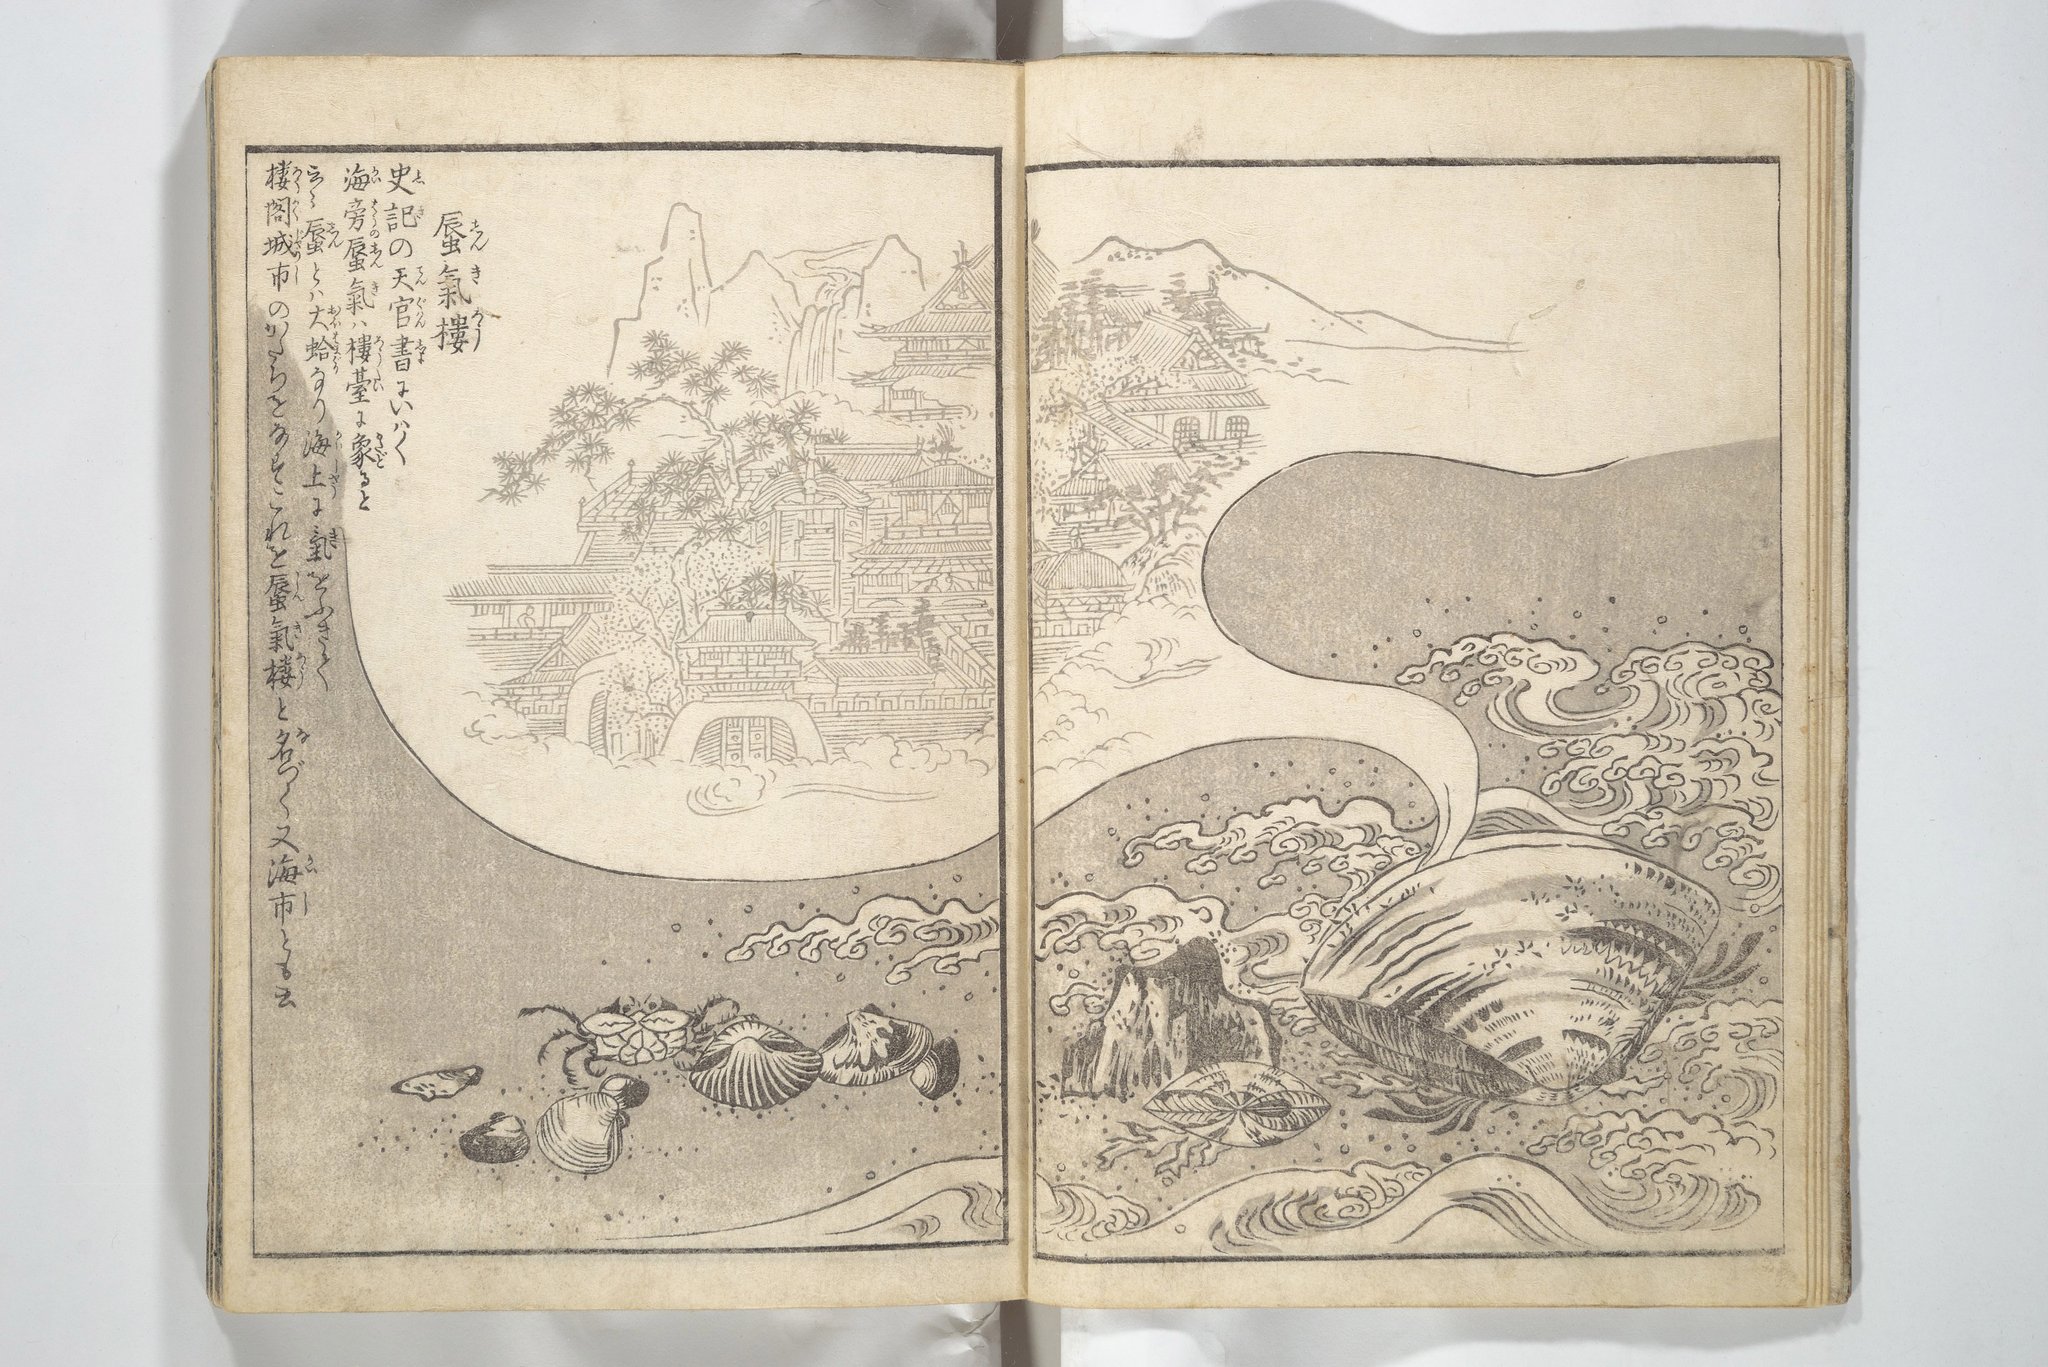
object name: illustrated book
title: One Hundred Monsters Ancient and Modern (Hyakki shūi) 百鬼拾遺; 今昔百鬼拾遺(こんじゃく ひゃっき しゅうい) ; 百鬼夜行拾遺(ひゃっき やぎょう しゅうい)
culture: japanese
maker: toriyama sekien 鳥山石燕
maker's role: artist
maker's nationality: japanese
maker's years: 1712-1788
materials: ink, paper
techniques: bookbinding, woodblock print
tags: houses,crabs,snails